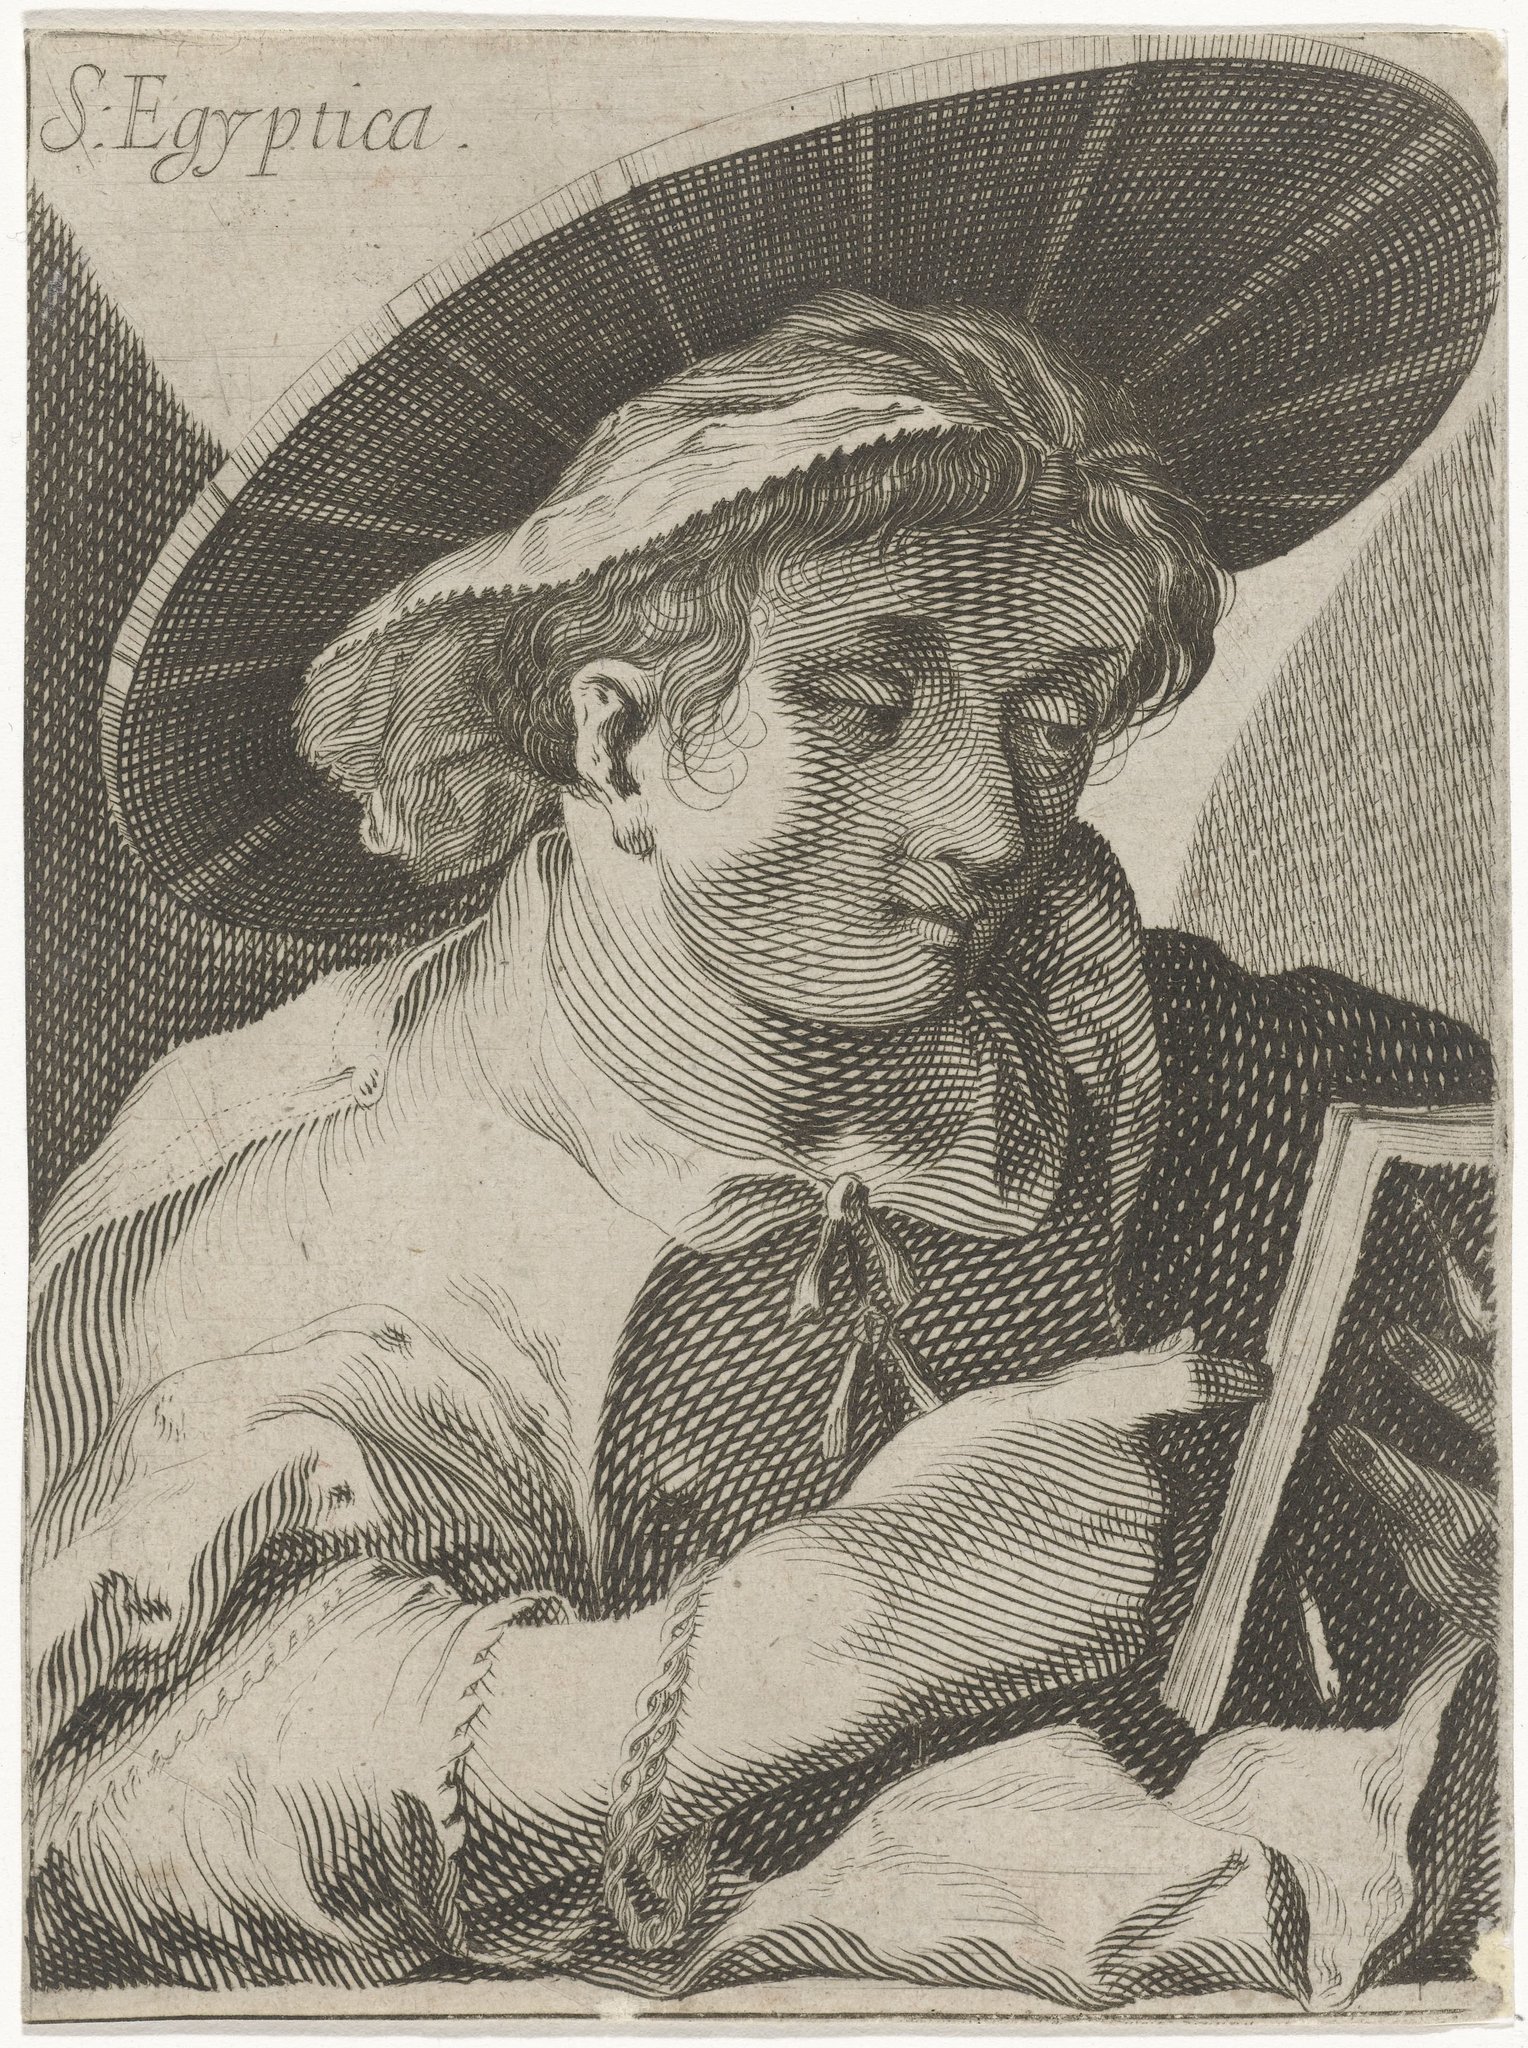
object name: print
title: S: Egyptica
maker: simon frisius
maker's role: print maker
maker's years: 1570-1628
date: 1595-1628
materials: paper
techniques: engraving, etching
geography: northern netherlands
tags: sibyls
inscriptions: collector's mark: Lugt 1838, collector's mark: Lugt 240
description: Sibille van Egypte, ten halven lijve, lezend in haar boek.